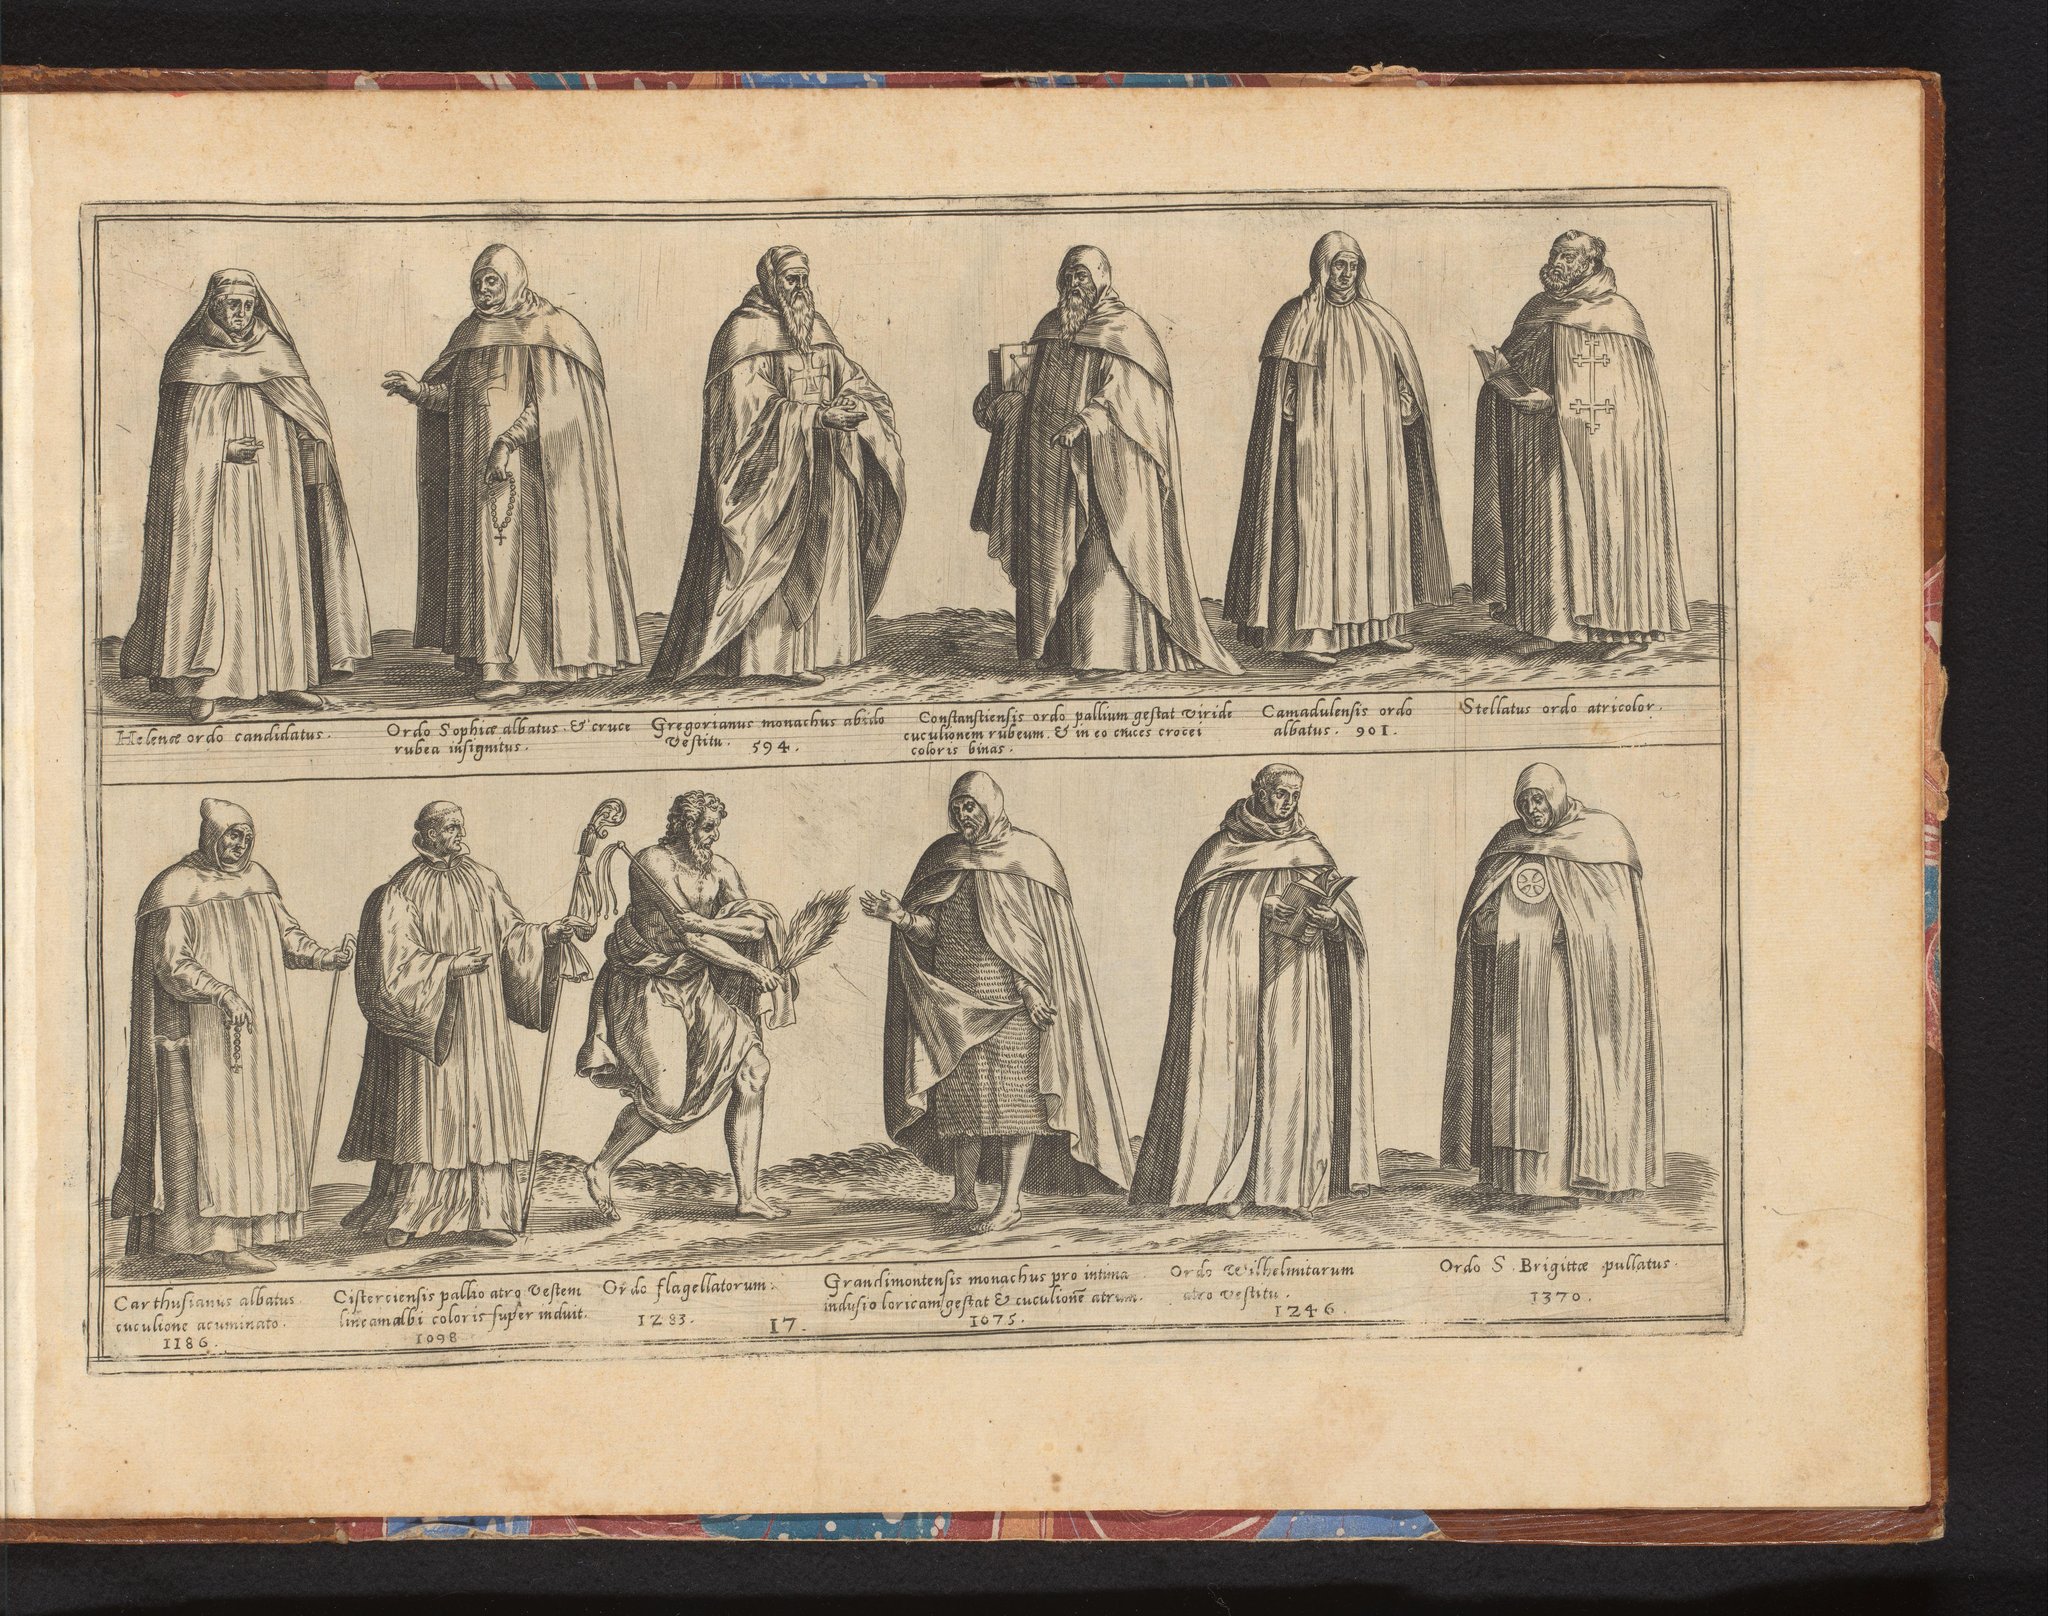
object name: album leaf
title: Twaalf monniken en monarchen uit verschillende orden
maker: abraham de bruyn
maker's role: print maker, publisher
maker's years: 1540-1587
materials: paper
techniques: engraving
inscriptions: number: ‘17’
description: In twee rijen boven elkaar. Prent uit het boek 'Omnium pene Europae, Asiae, Aphricae atque Americae gentium habitus...', 1581. De prent maakt deel uit van een album.